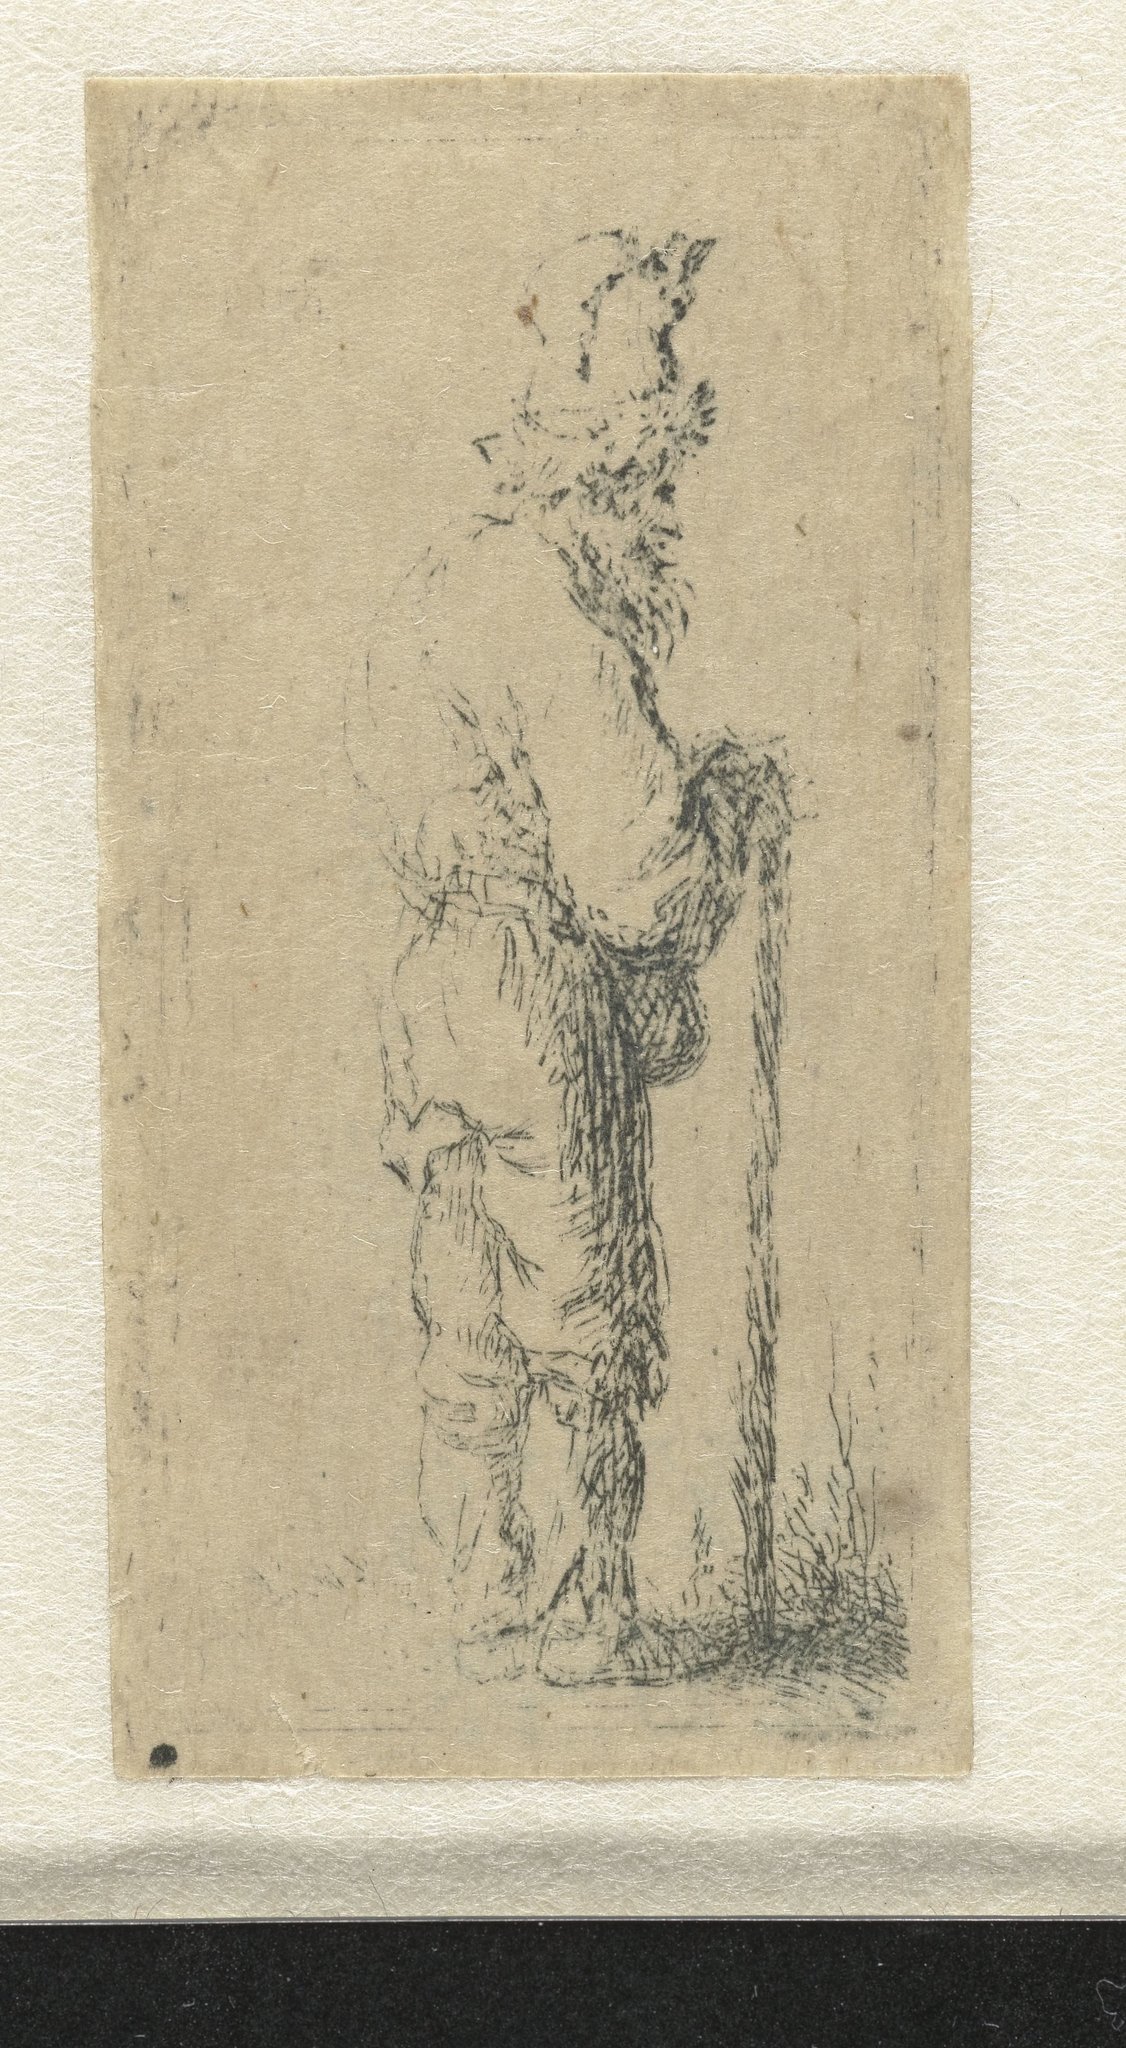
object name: print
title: Beggar leaning on a stick, facing left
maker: Anonymous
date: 1700-1799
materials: paper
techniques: etching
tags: landscapes, beggar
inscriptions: collector's mark: Lugt 2166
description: Spiegelbeeldige kopie naar de gelijknamige prent van Rembrandt.